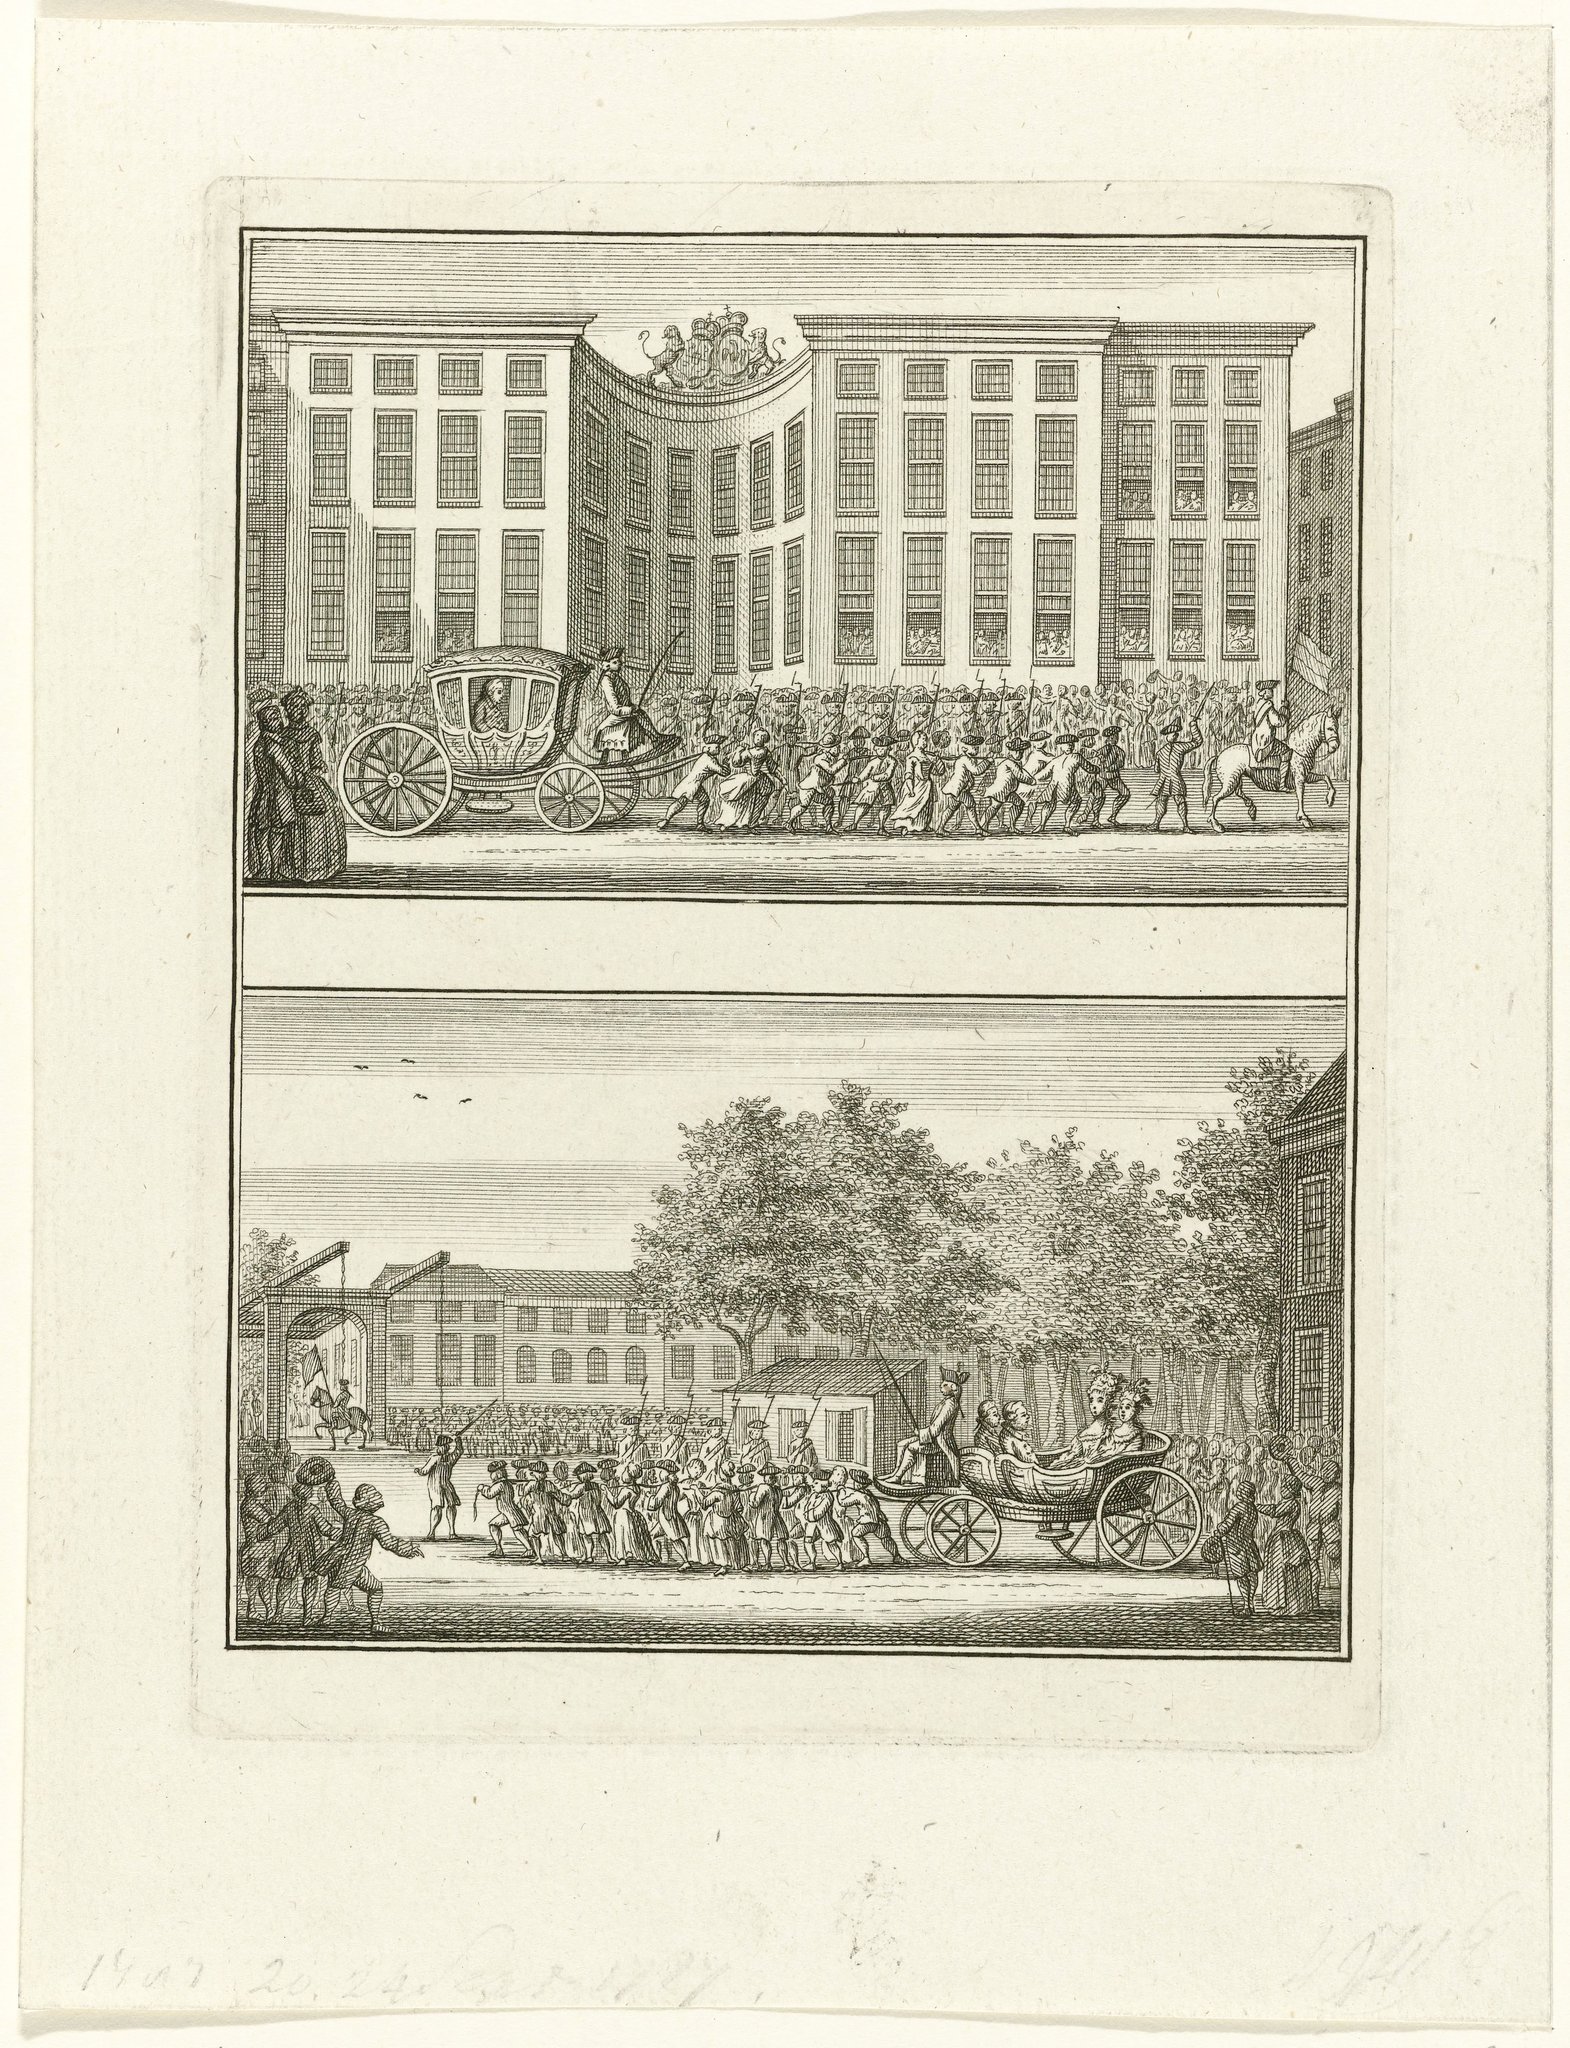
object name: print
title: Inhaling van de prins en prinses van Oranje, 1787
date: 1788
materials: paper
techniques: engraving, etching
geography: northern netherlands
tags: the hague, william v (prince of orange), berlin, painter, draughtsman, wilhelmina of prussia (princess of orange), public festivities at other royal events, not meant or mentioned above, human being(s) drawing or pushing a vehicle not usually propelled by manpower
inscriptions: collector's mark: Lugt 2228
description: Blad met twee voorstellingen van de inhaling van de prins van Oranje door de burgerij te Den Haag op 20 september en de prinses van Oranje met de kinderen op 24 september 1787.